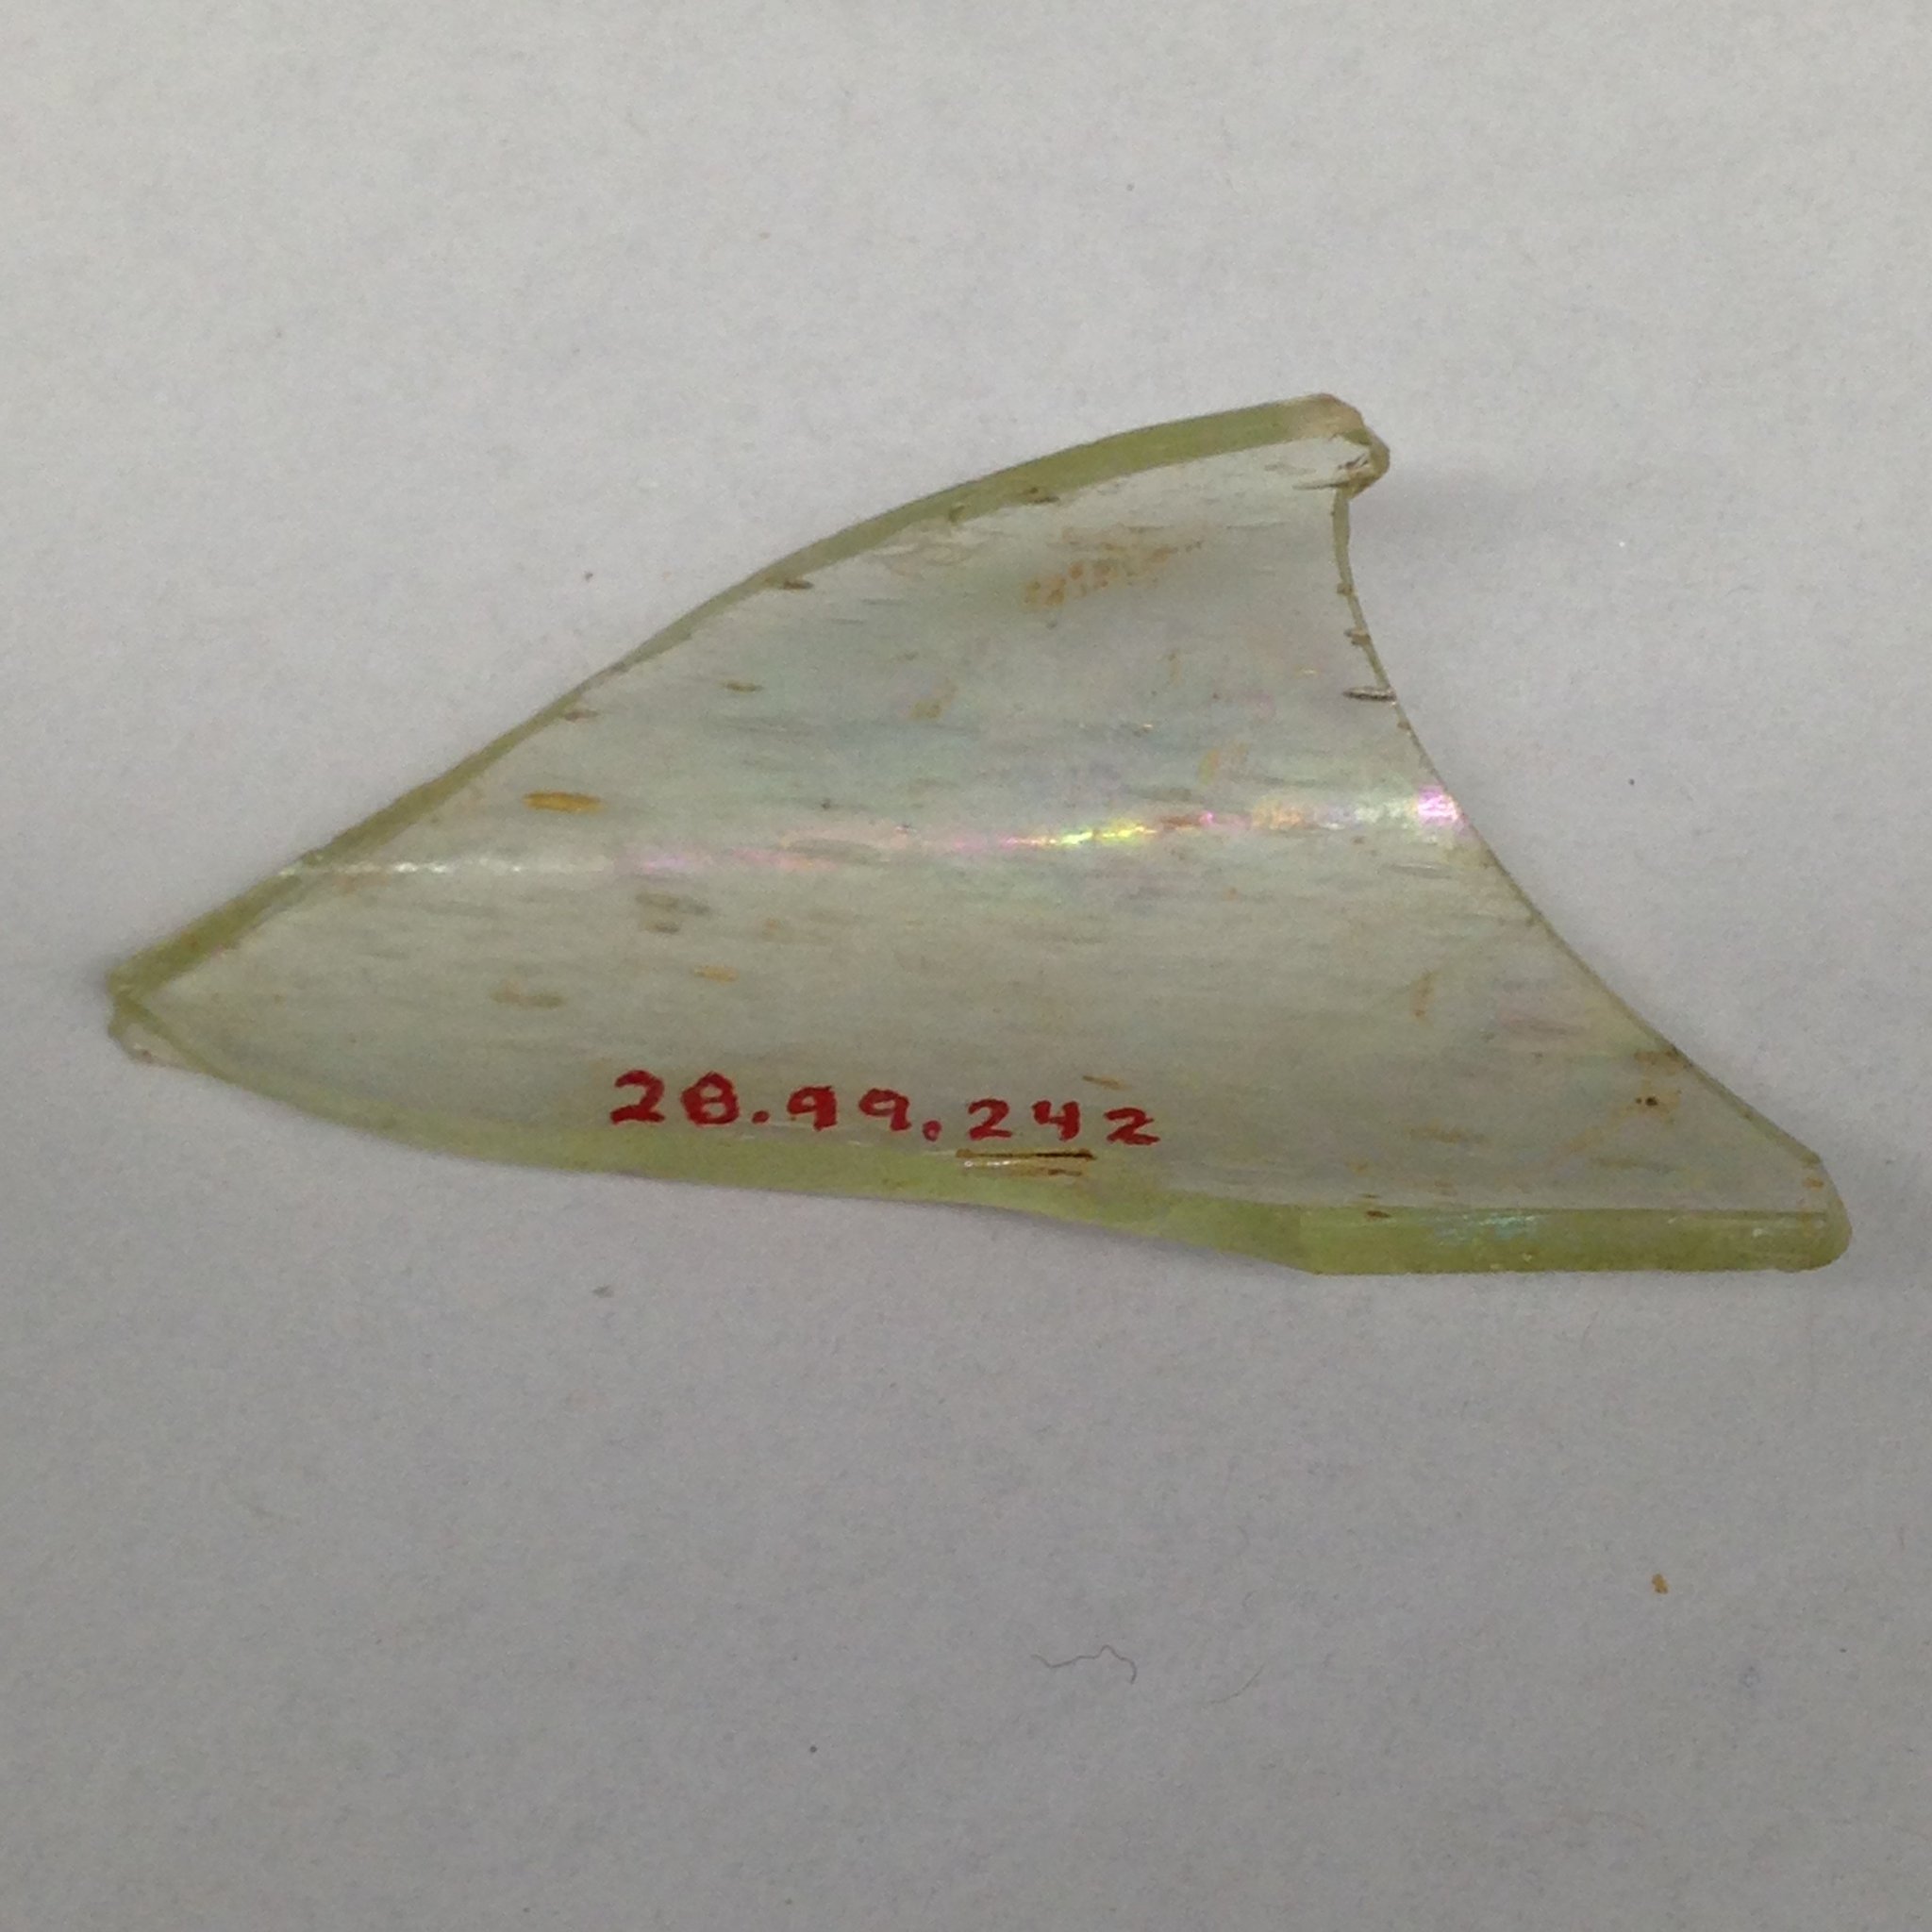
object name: fragment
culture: european or middle eastern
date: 1150-1250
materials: ceramic, glass